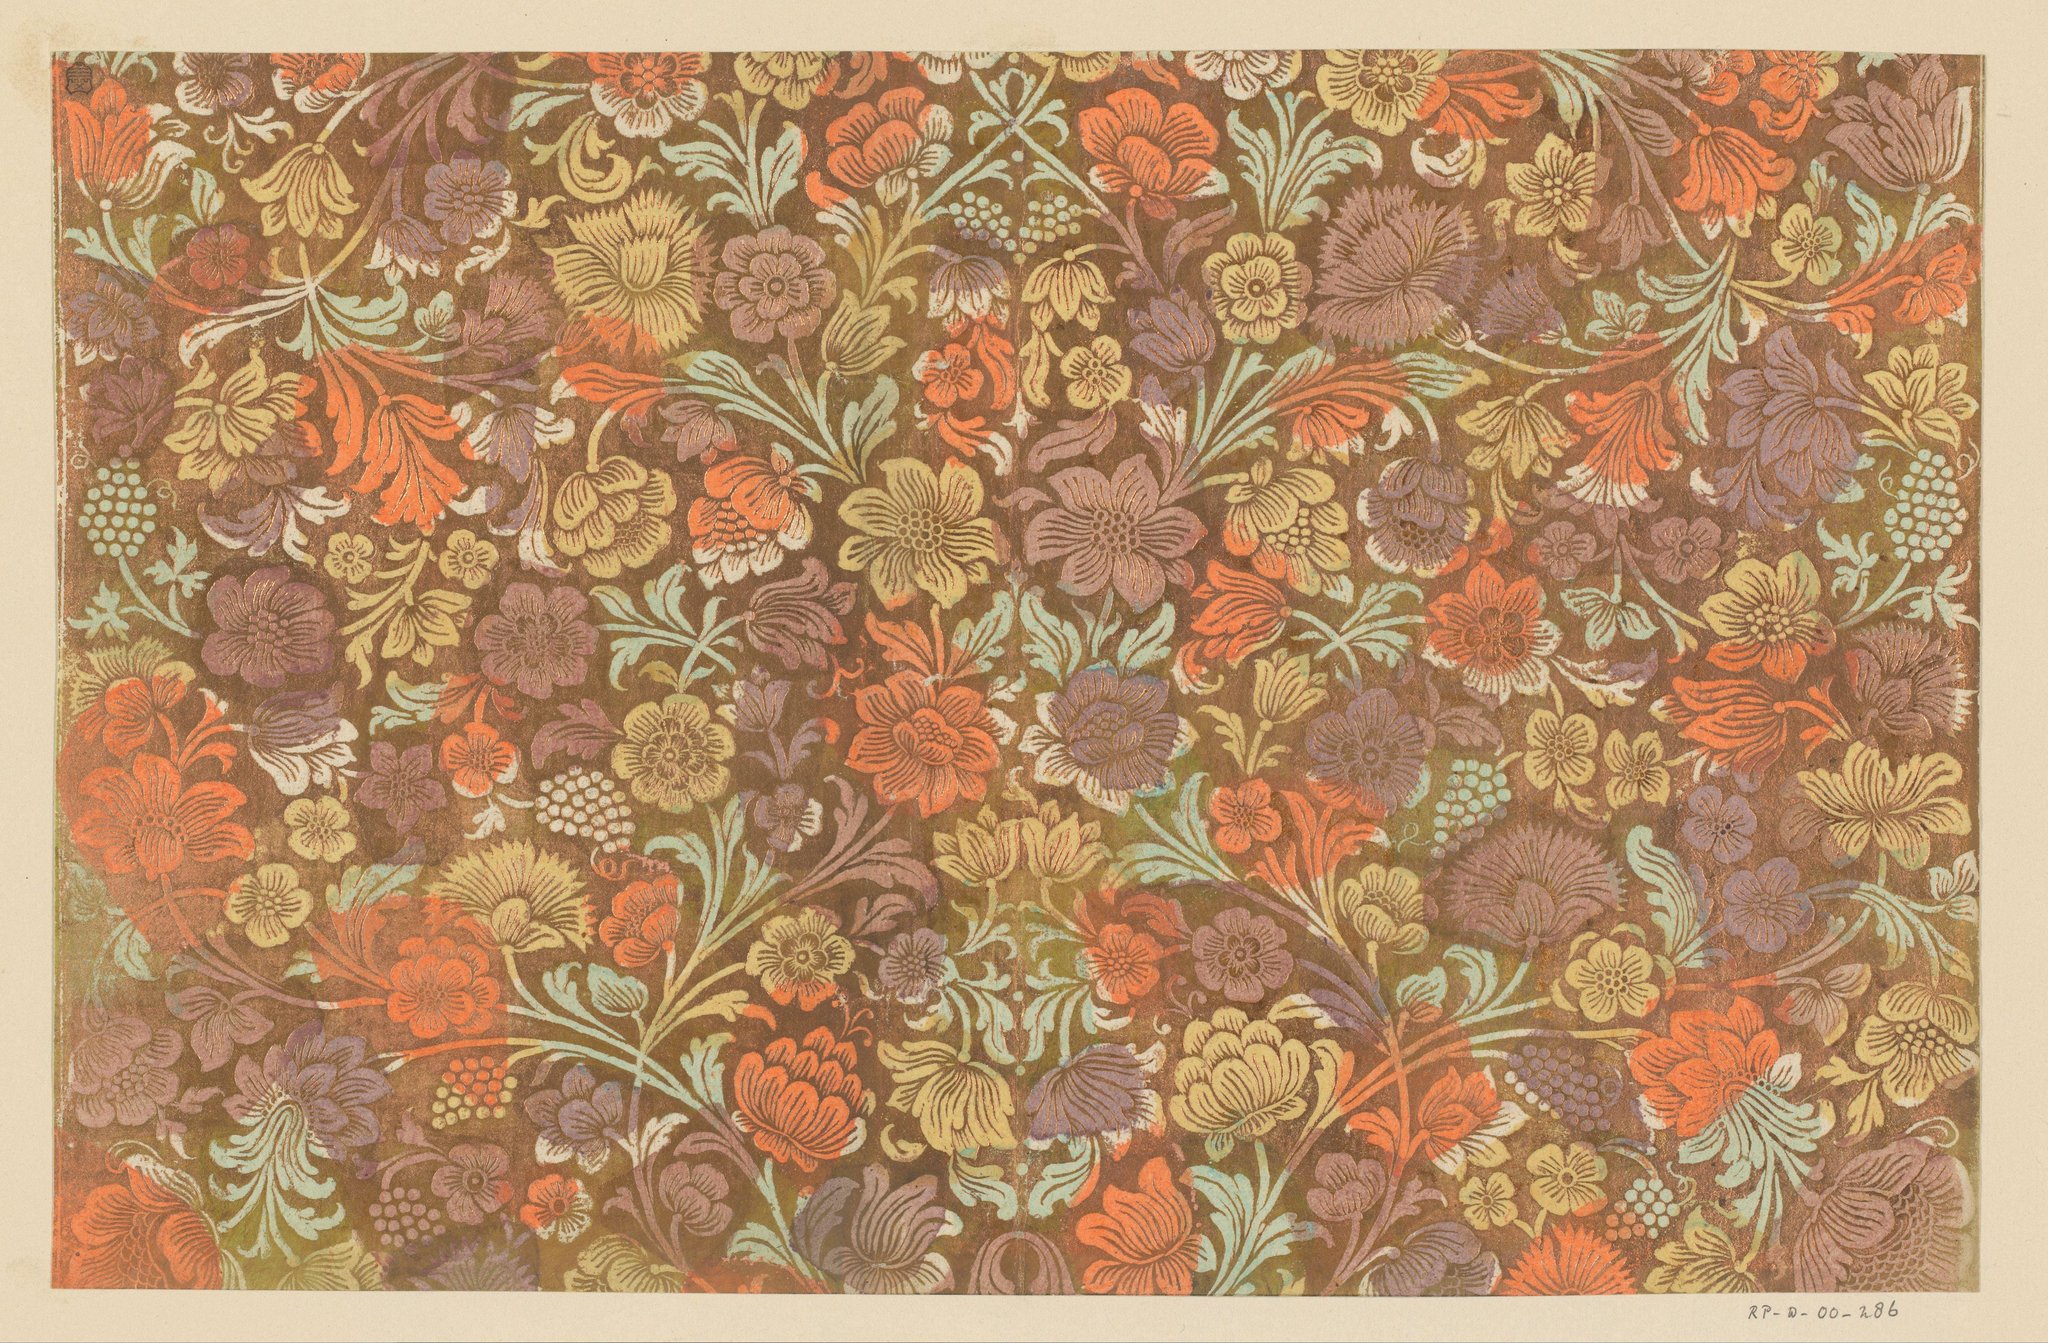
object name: brocade paper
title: Blad met bloemen en vruchten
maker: Anonymous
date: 1750-1800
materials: gold leaf, paint, paper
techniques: relief print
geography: germany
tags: ornament derived from plant forms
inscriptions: collector's mark: Lugt 2760